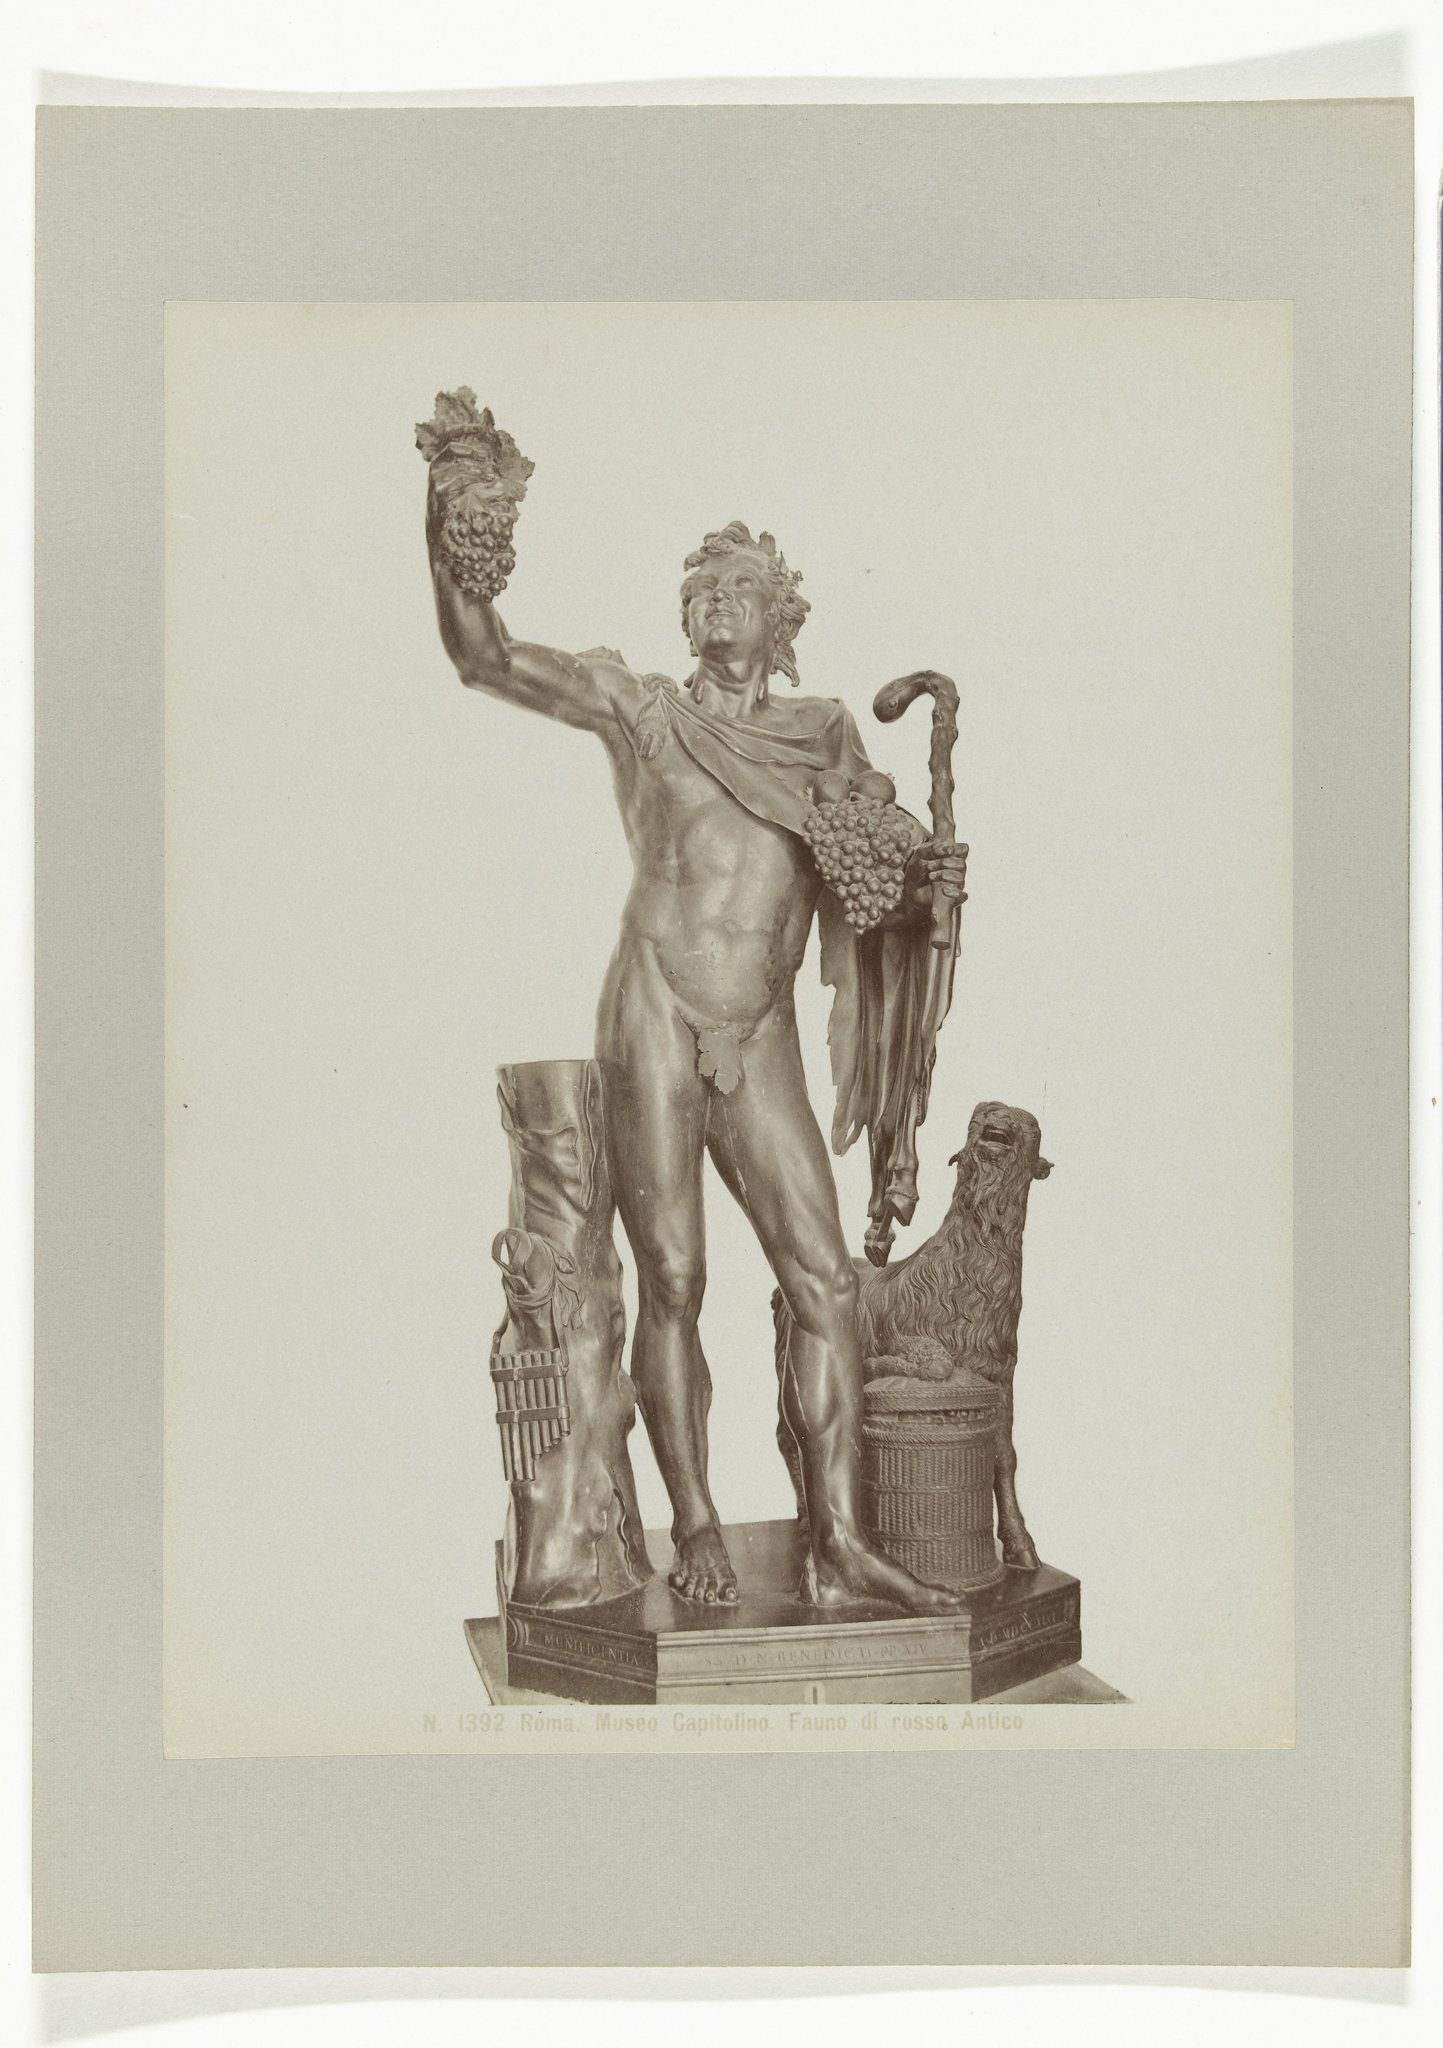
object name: photograph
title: Sculptuur van Rode Faun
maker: Anonymous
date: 1880-1904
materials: cardboard, paper, photographic support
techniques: albumen print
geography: rome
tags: rome